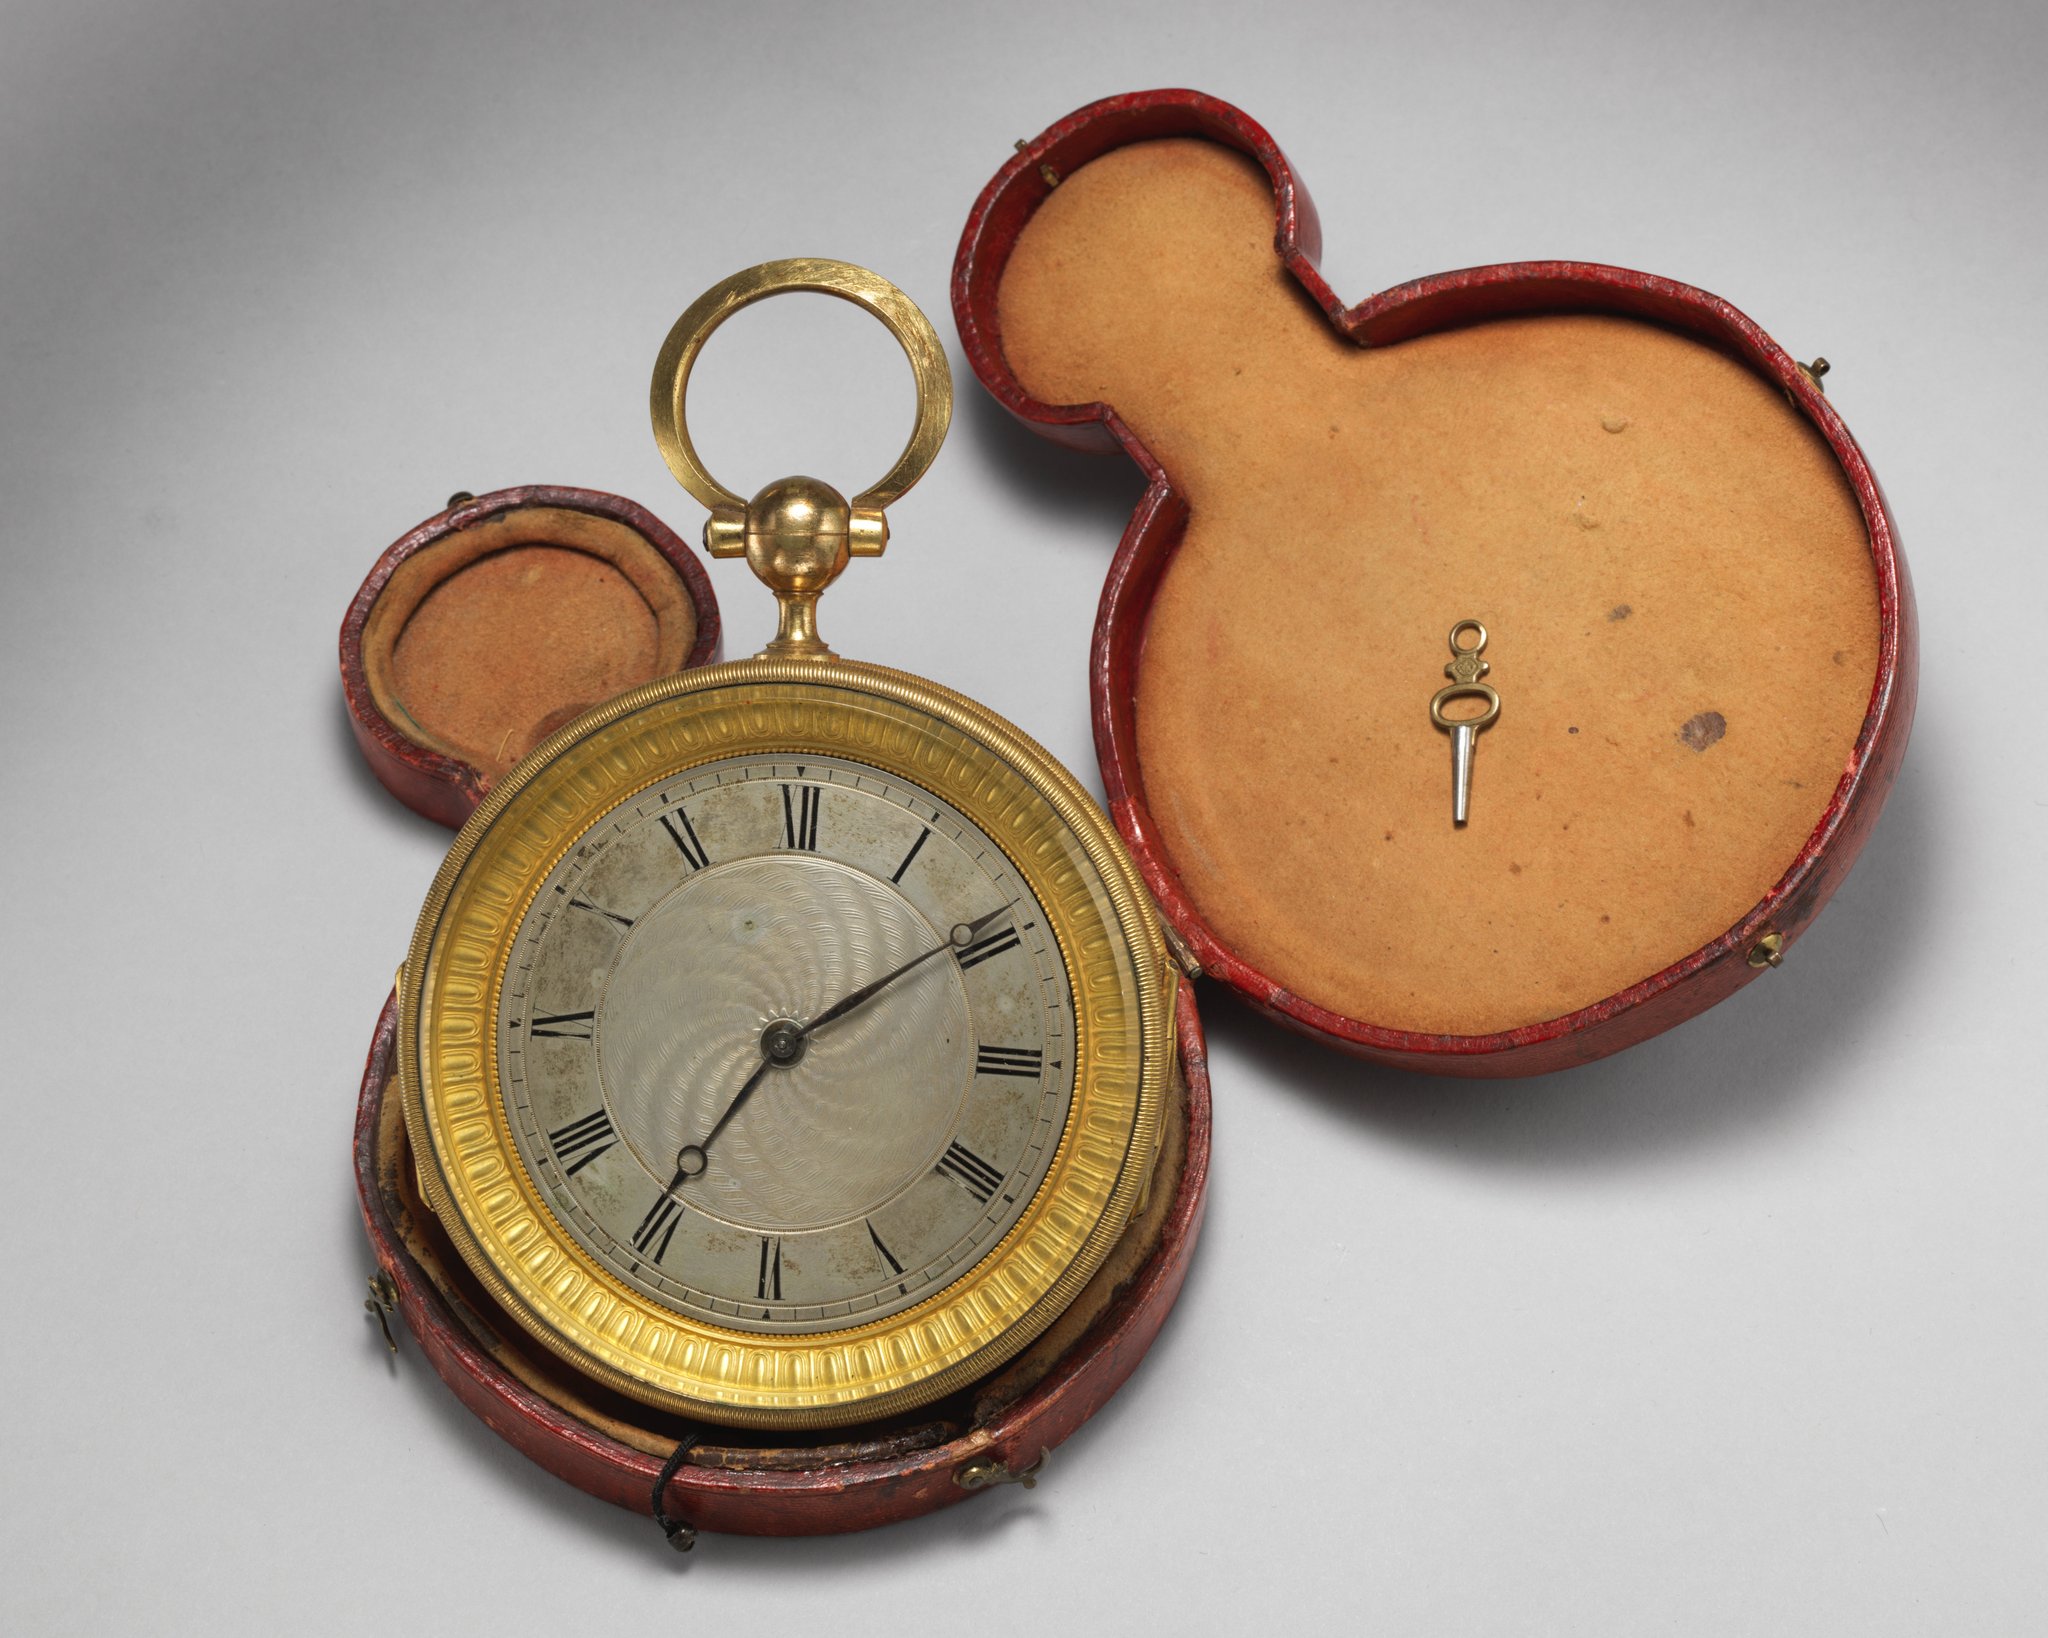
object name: watch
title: Round watch with key in original red leather case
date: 1767-1800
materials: gilt bronze, leather, steel